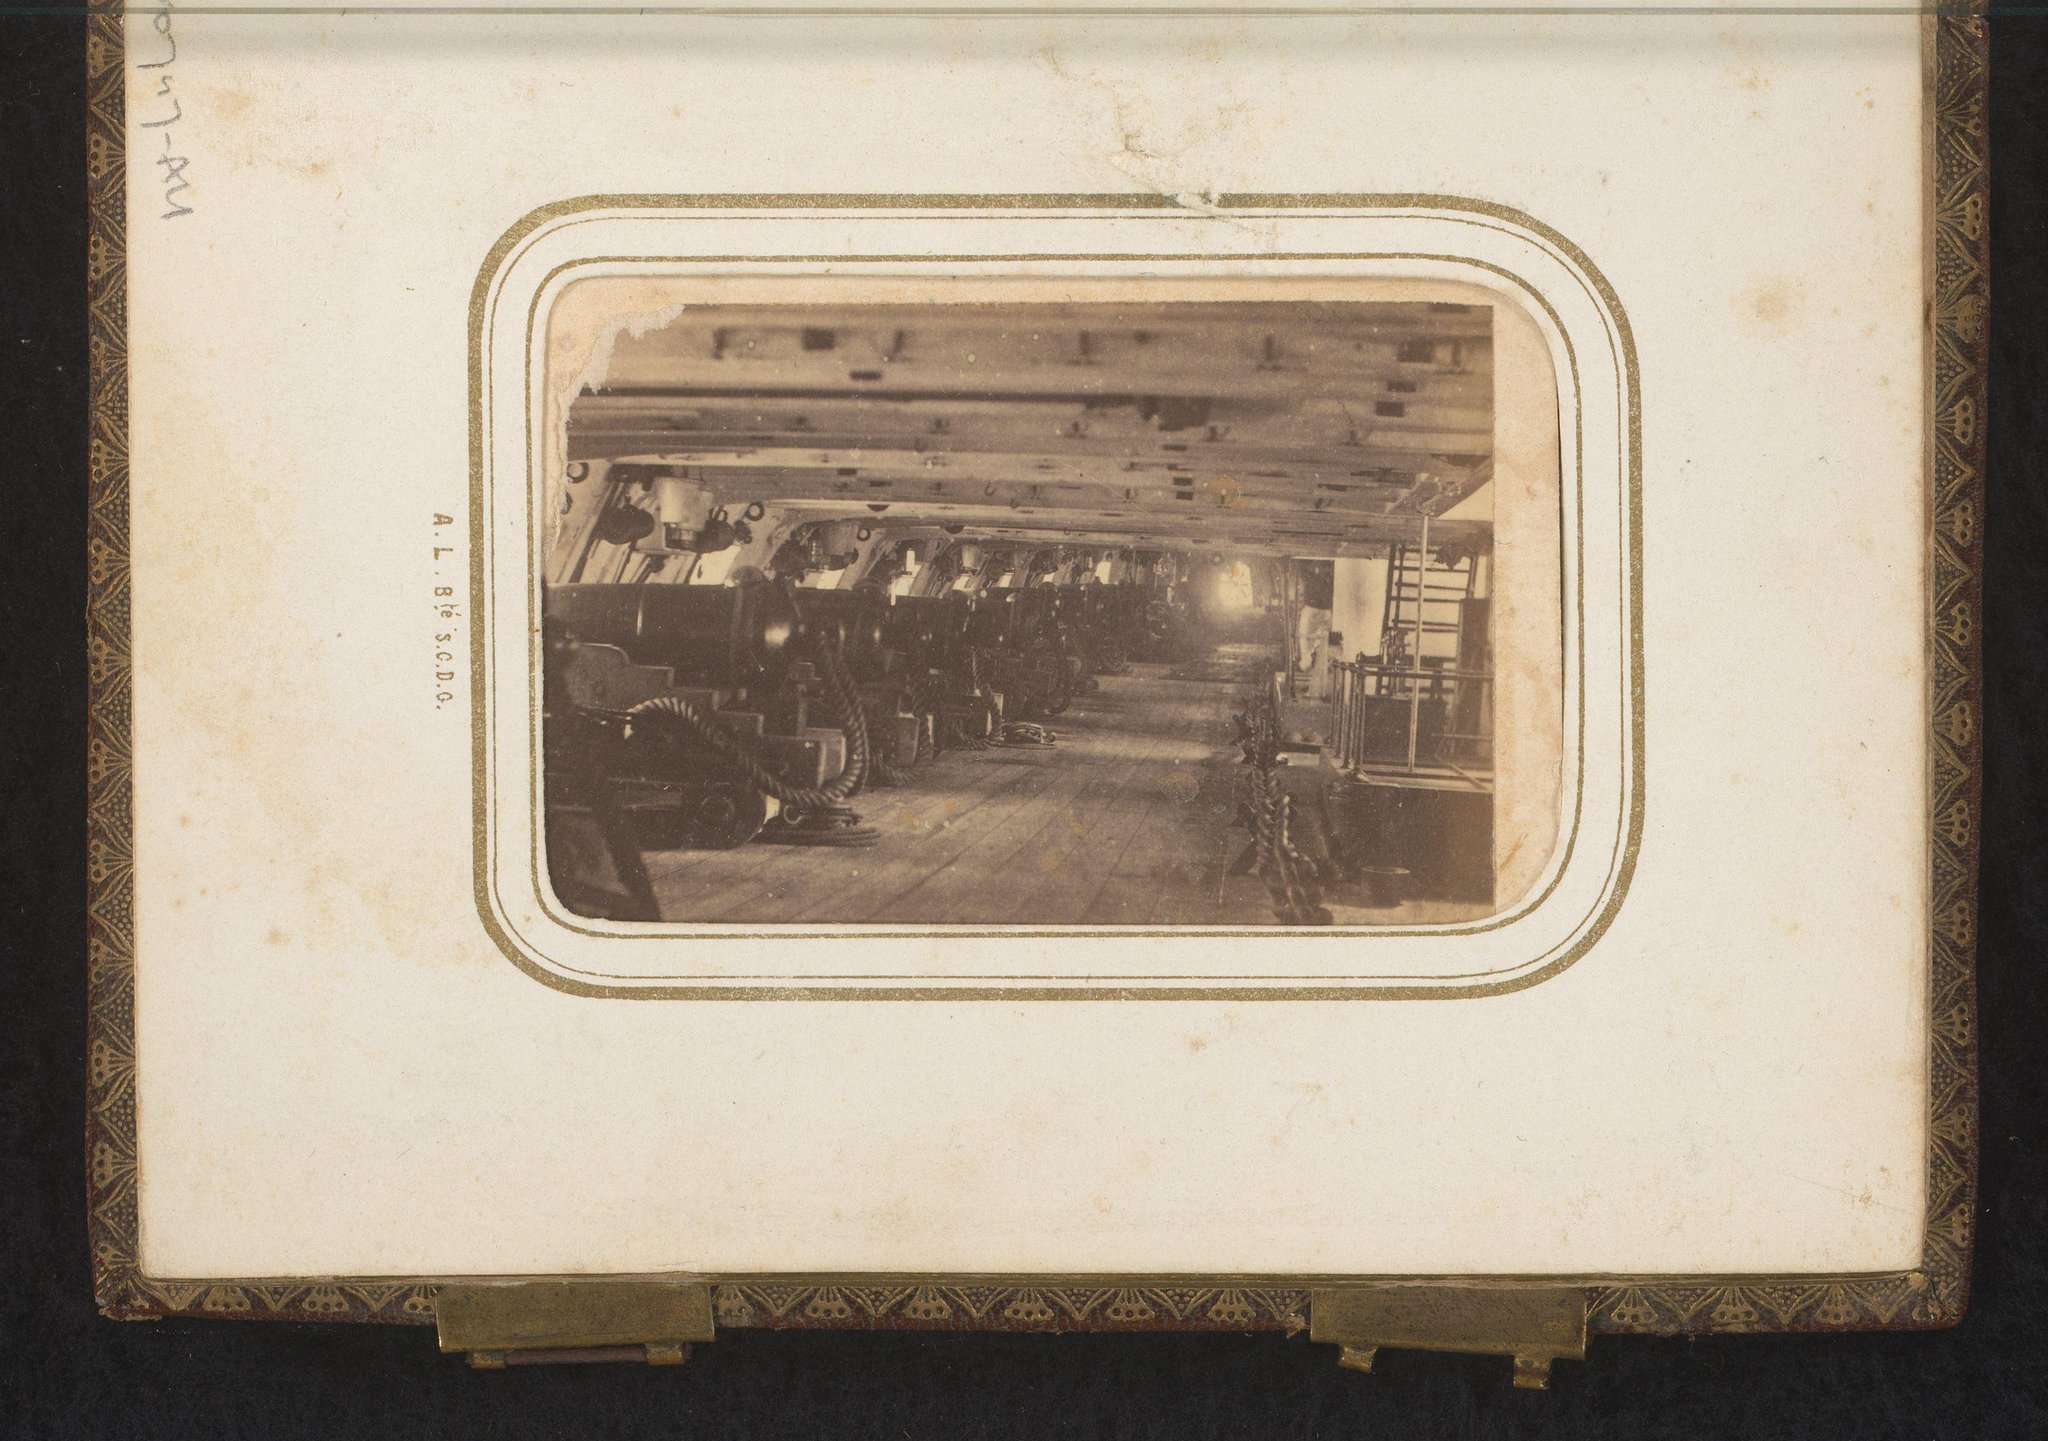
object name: album leaf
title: Kanonnen op een schip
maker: Anonymous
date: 1860-1890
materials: cardboard, photographic support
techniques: albumen print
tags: ships (in general), firearms: cannon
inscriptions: inscription: ‘Fotografia/ 17 Calle del cerro 17/ Montevideo’, inscription: ‘A.L. B.te S.C.D.G.’